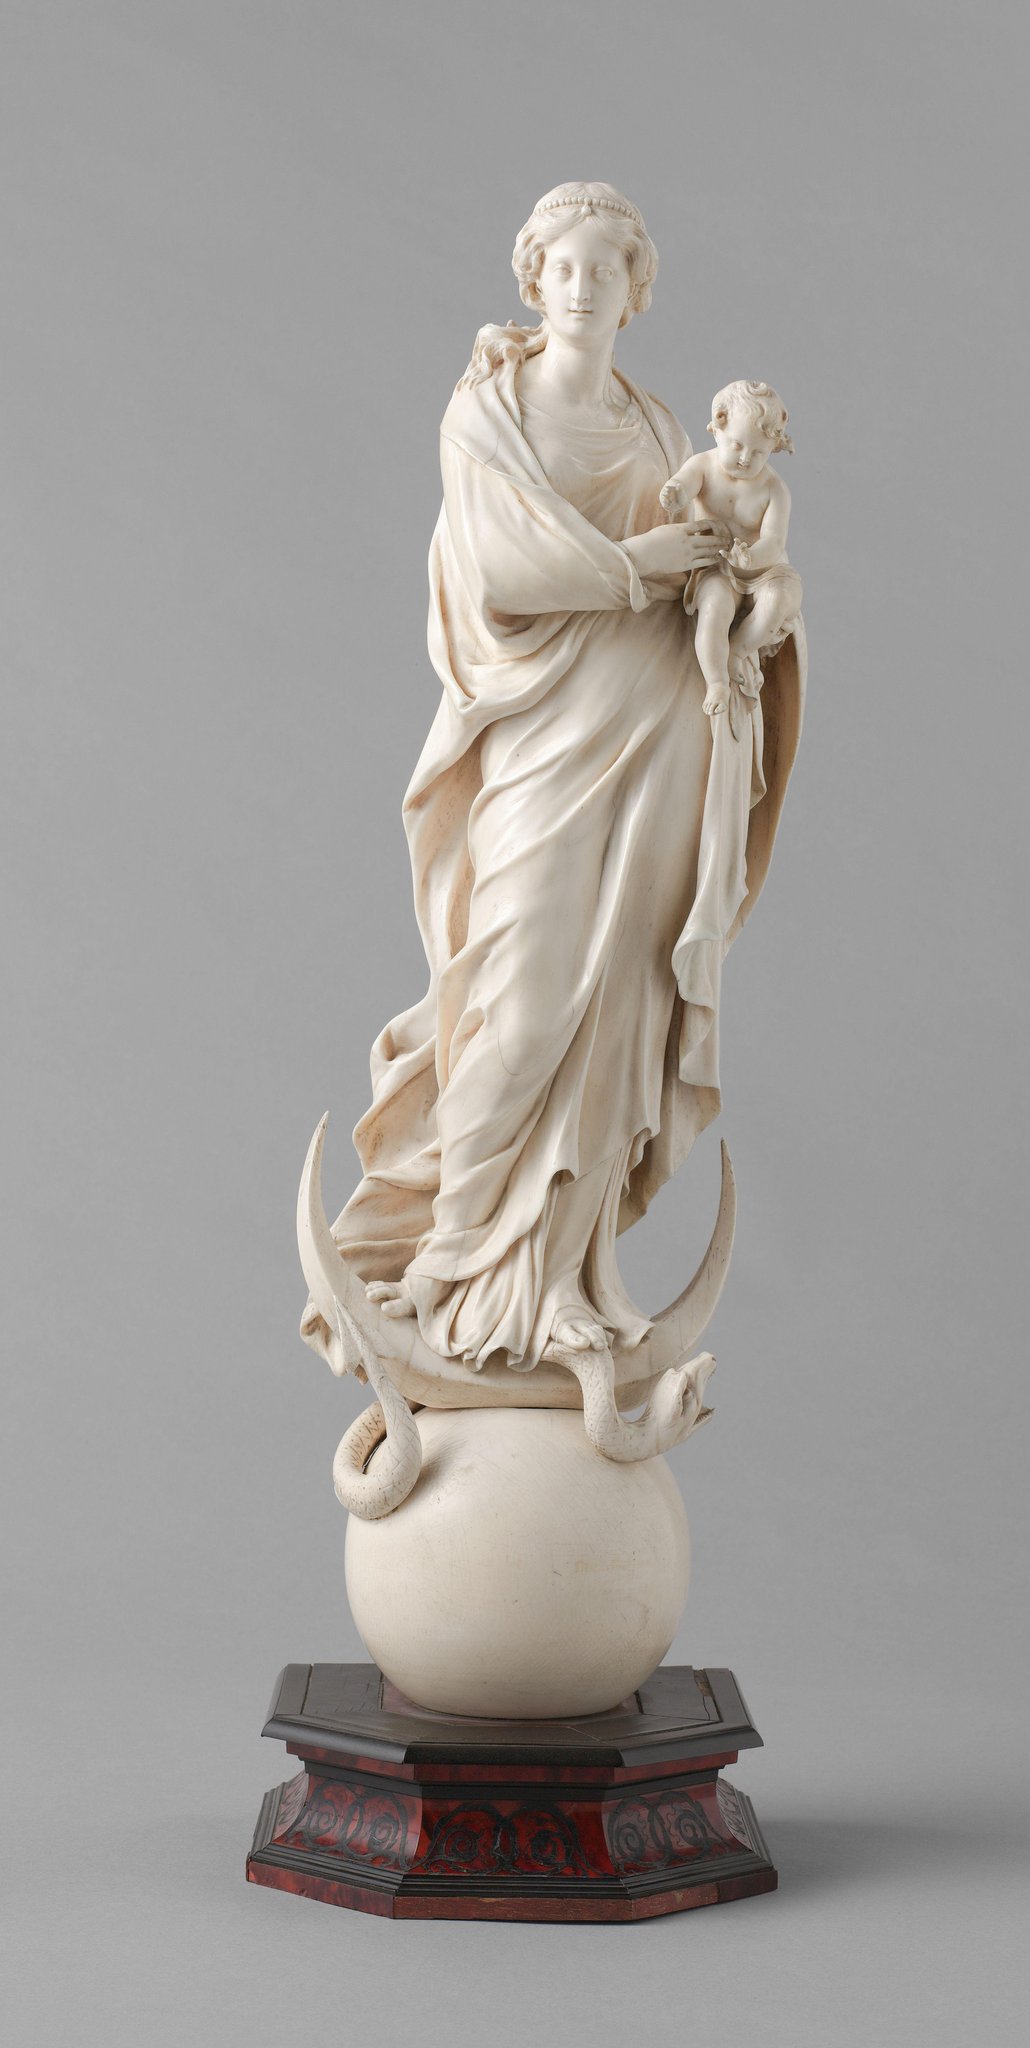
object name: sculpture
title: St Mary of Victory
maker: mattheus van beveren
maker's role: ivory carver, sculptor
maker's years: 1630-1690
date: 1680-1690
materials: ivory, shell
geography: antwerp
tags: madonna on the crescent of the moon (sometimes called queen of heaven) (in mandorla)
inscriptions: label, on the reverse, in printed letters: ‘Oude Vlaamsche Kunst / ANTWERPEN 1930’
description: The Virgin is represented as the Woman of the Apocalypse from the New Testament Book of Revelation. Standing on the crescent moon (the Jewish synagogue), she personifies the Christian Church. With the exception of the globe and the tips of the moon, this imposing figure has been carved from a single large piece of elephant tusk.